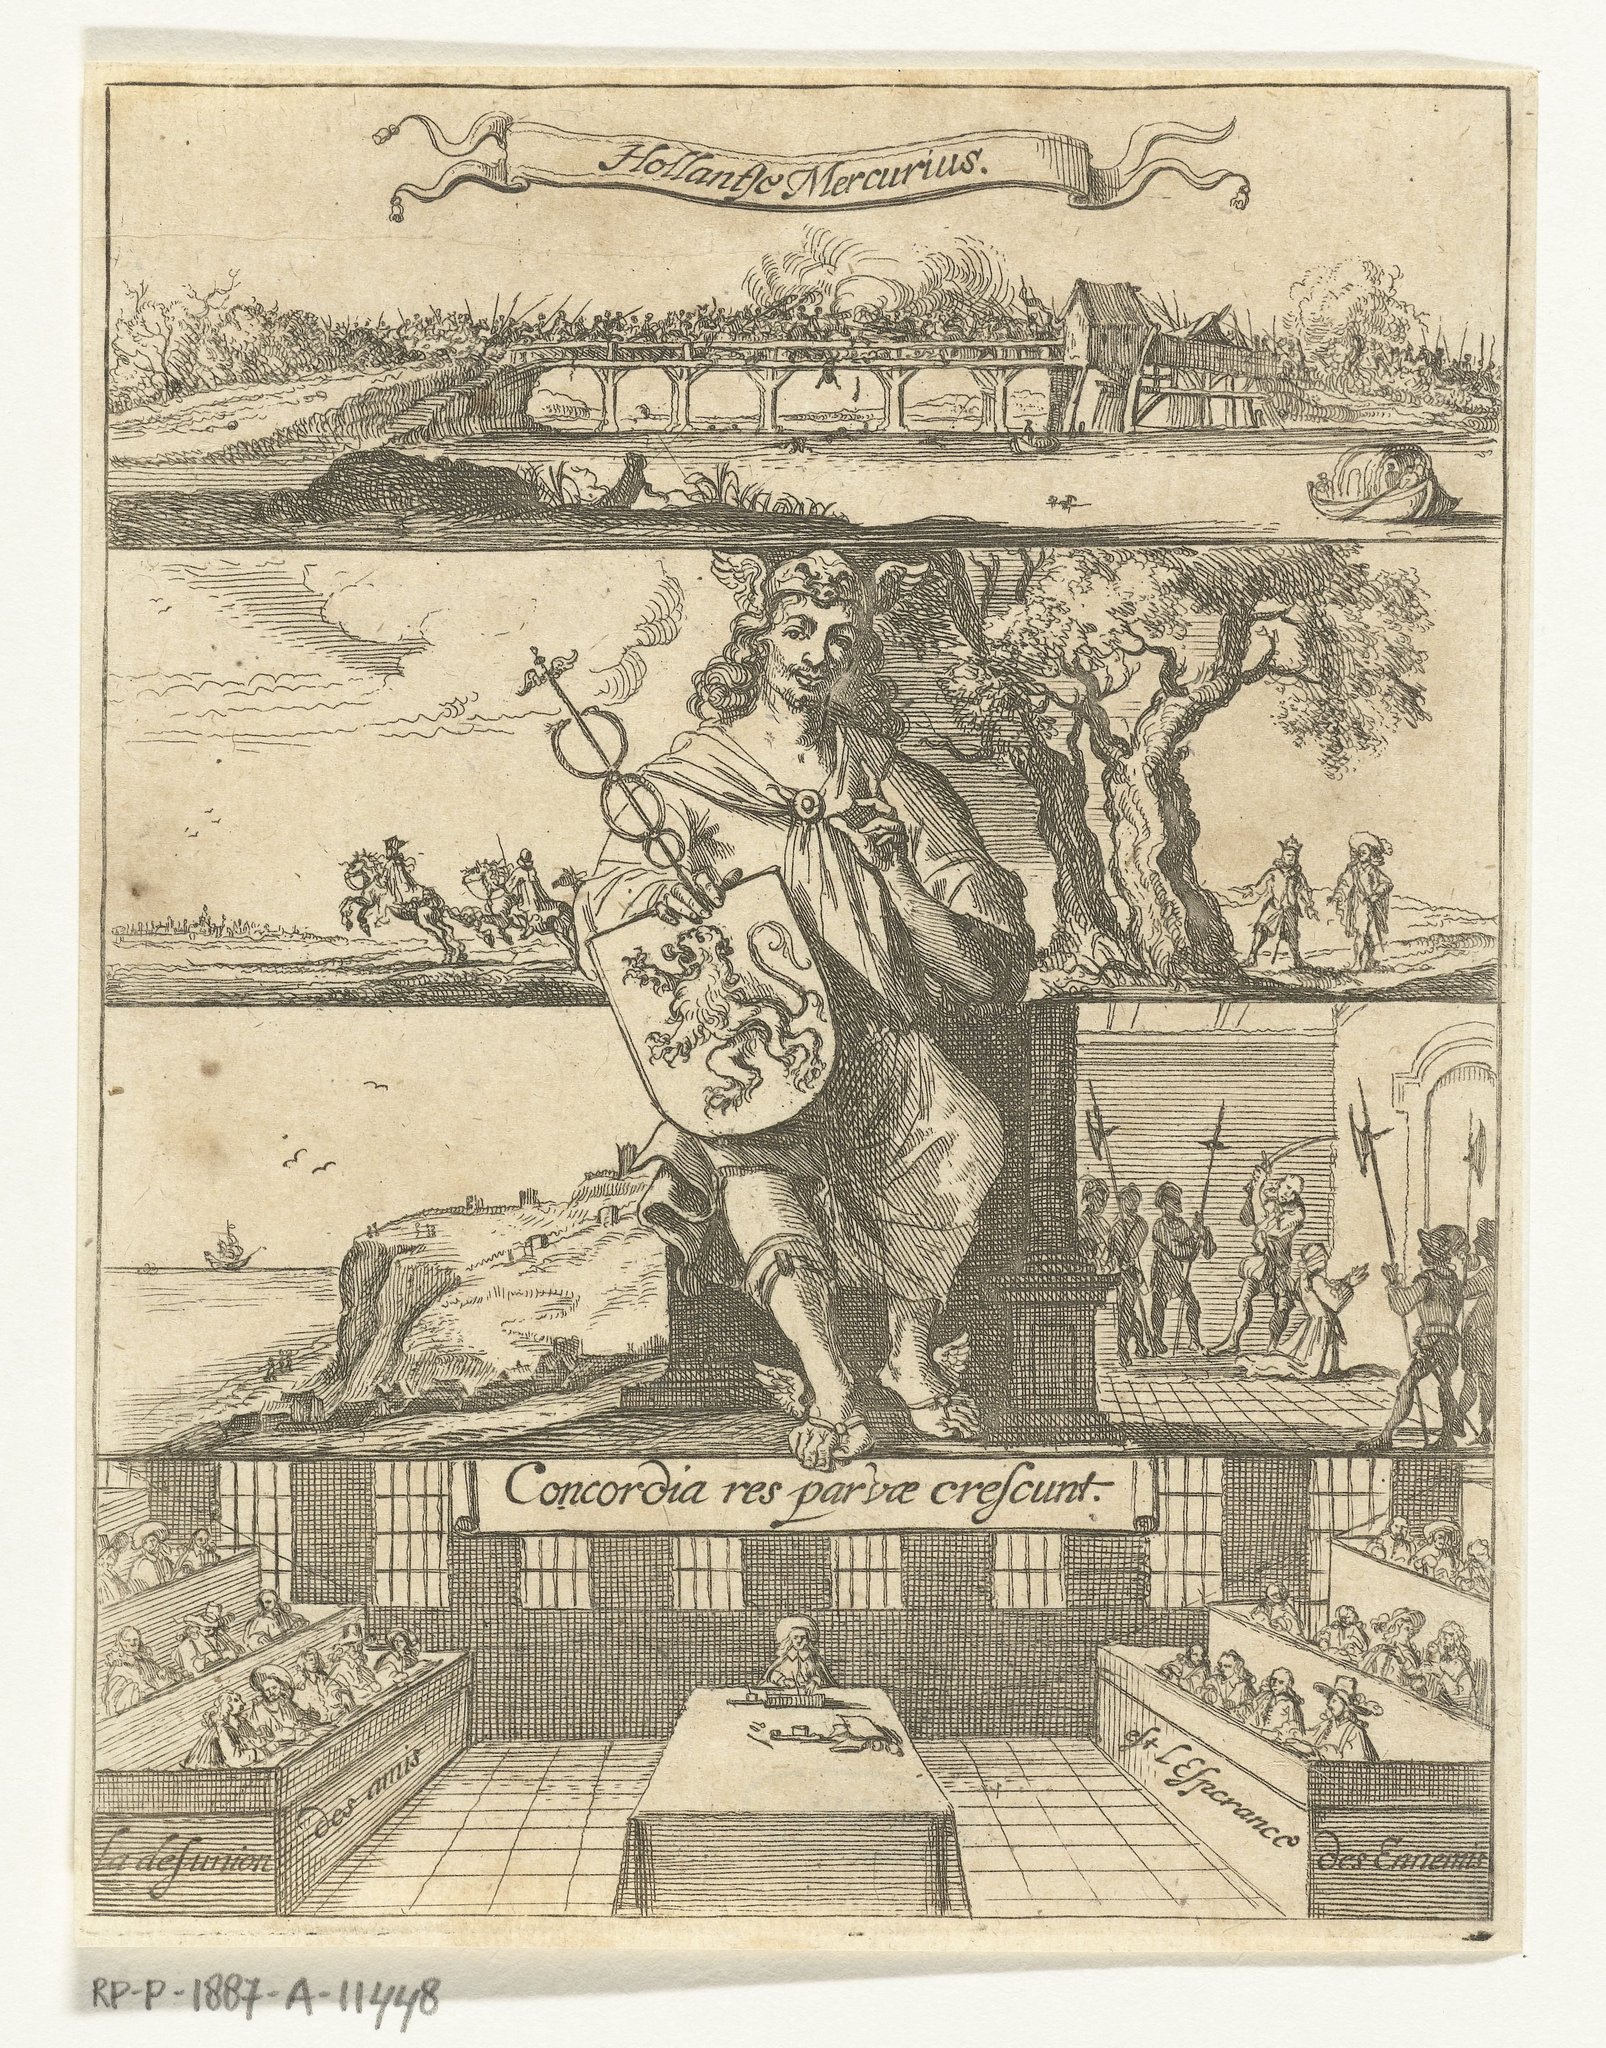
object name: print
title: Titelpagina voor: Hollantse Mercurius, Haarlem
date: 1645-1694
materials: paper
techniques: etching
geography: netherlands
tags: specific aspects, allegorical aspects of mercury; mercury as patron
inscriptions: collector's mark: Lugt 2228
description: Verschillende scènes met gebeurtenissen in Europa in onbekend jaar met tronende Mercurius als beschermer van de handel. Boven een scène met een vergadering staat in Latijn concordia res parvae crescunt (eendracht maakt macht).